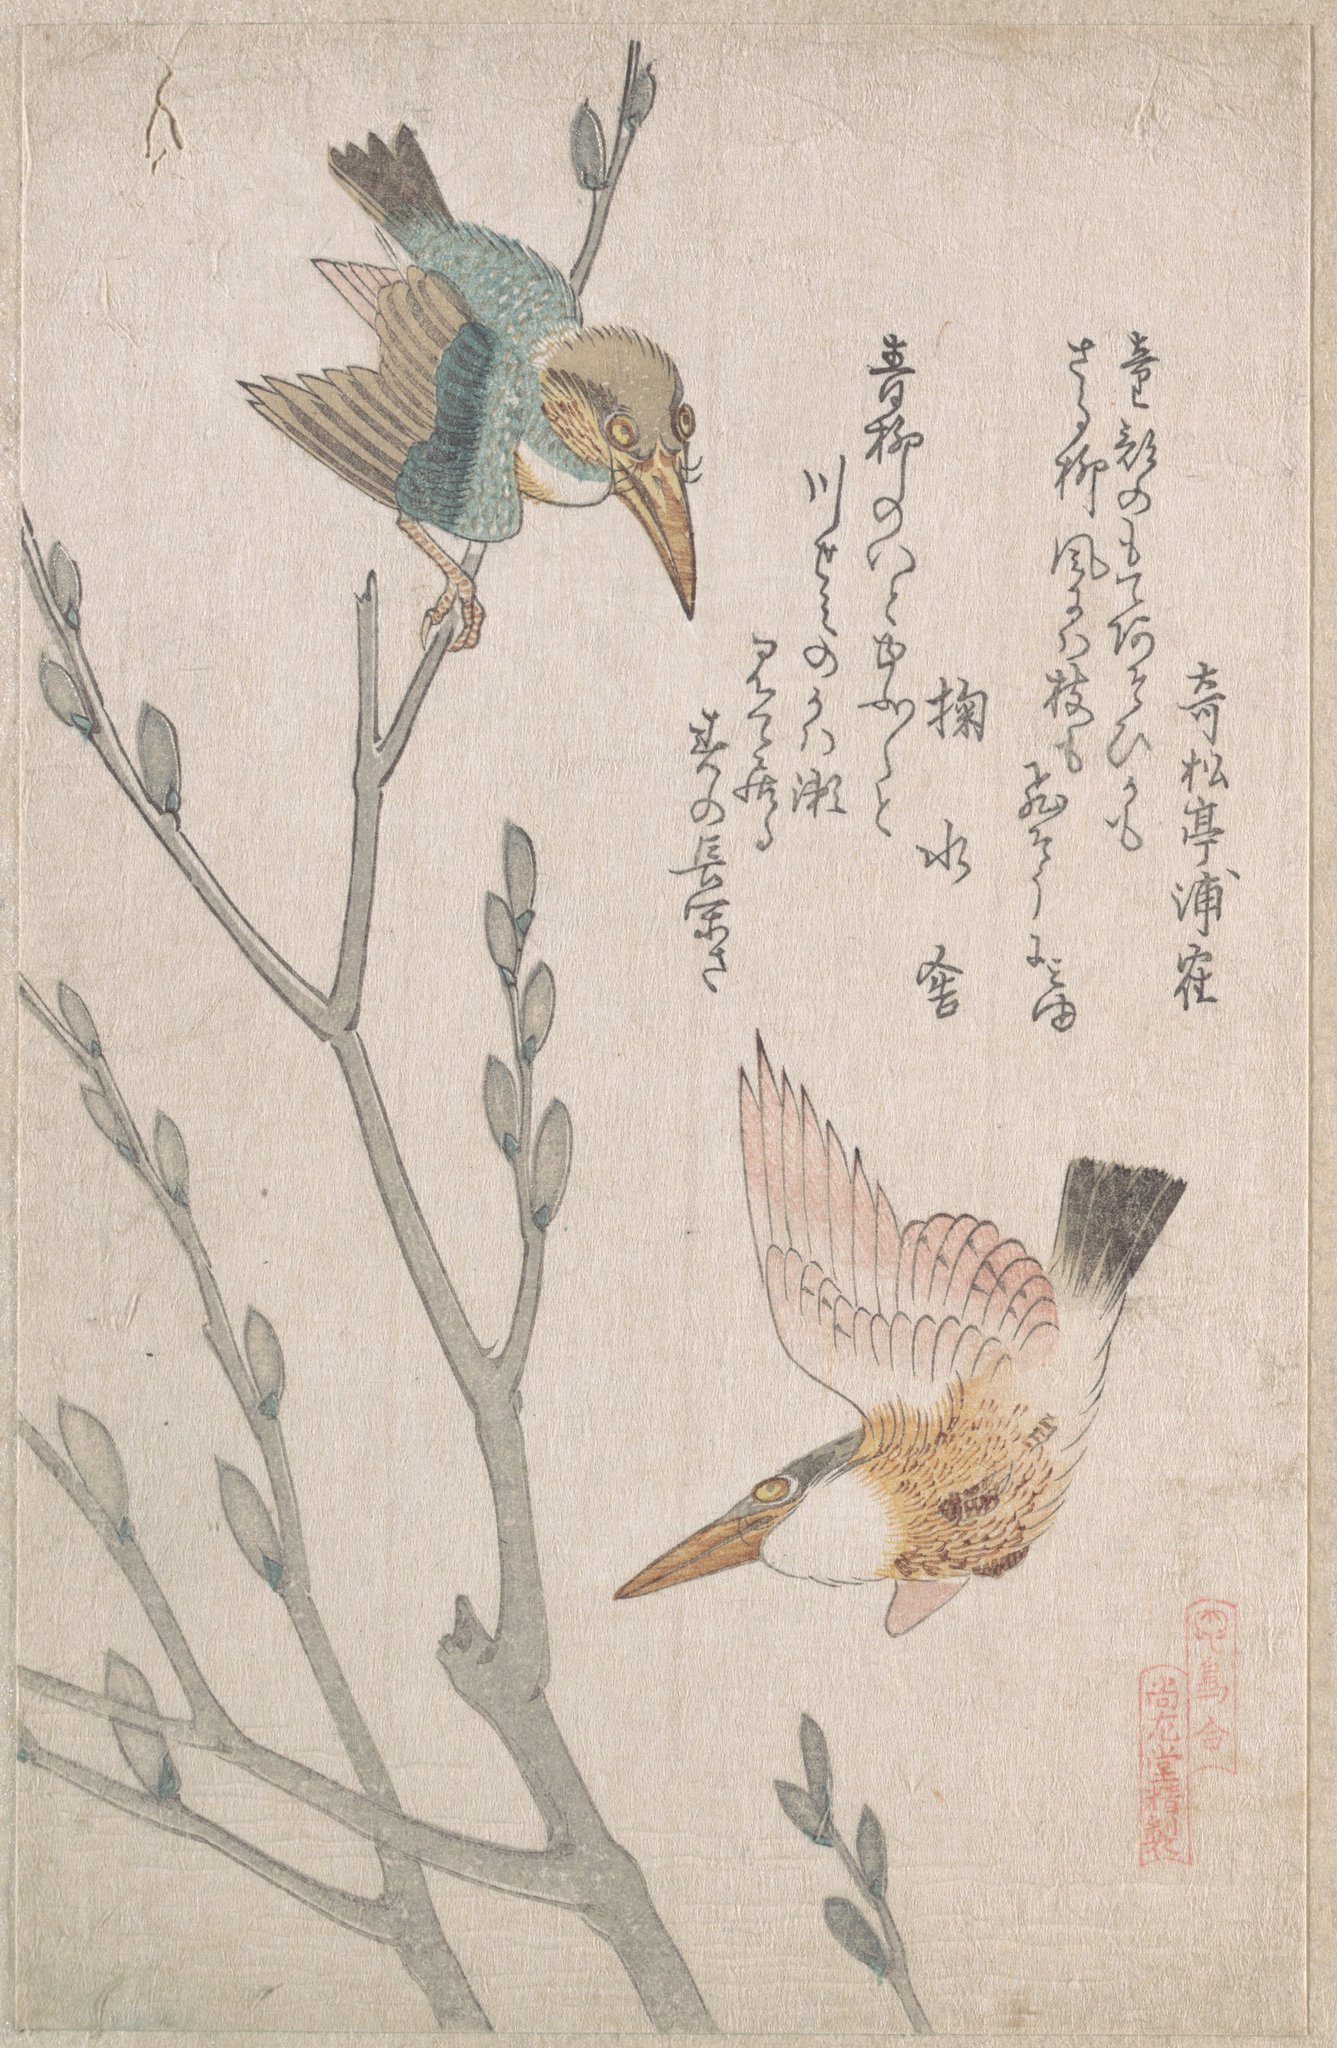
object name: woodblock print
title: Kingfishers and Pussy-willow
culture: japanese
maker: kubo shunman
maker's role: artist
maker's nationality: japanese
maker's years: 1757-1820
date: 1801-1900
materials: ink, paper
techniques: surimono, woodblock print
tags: birds,trees